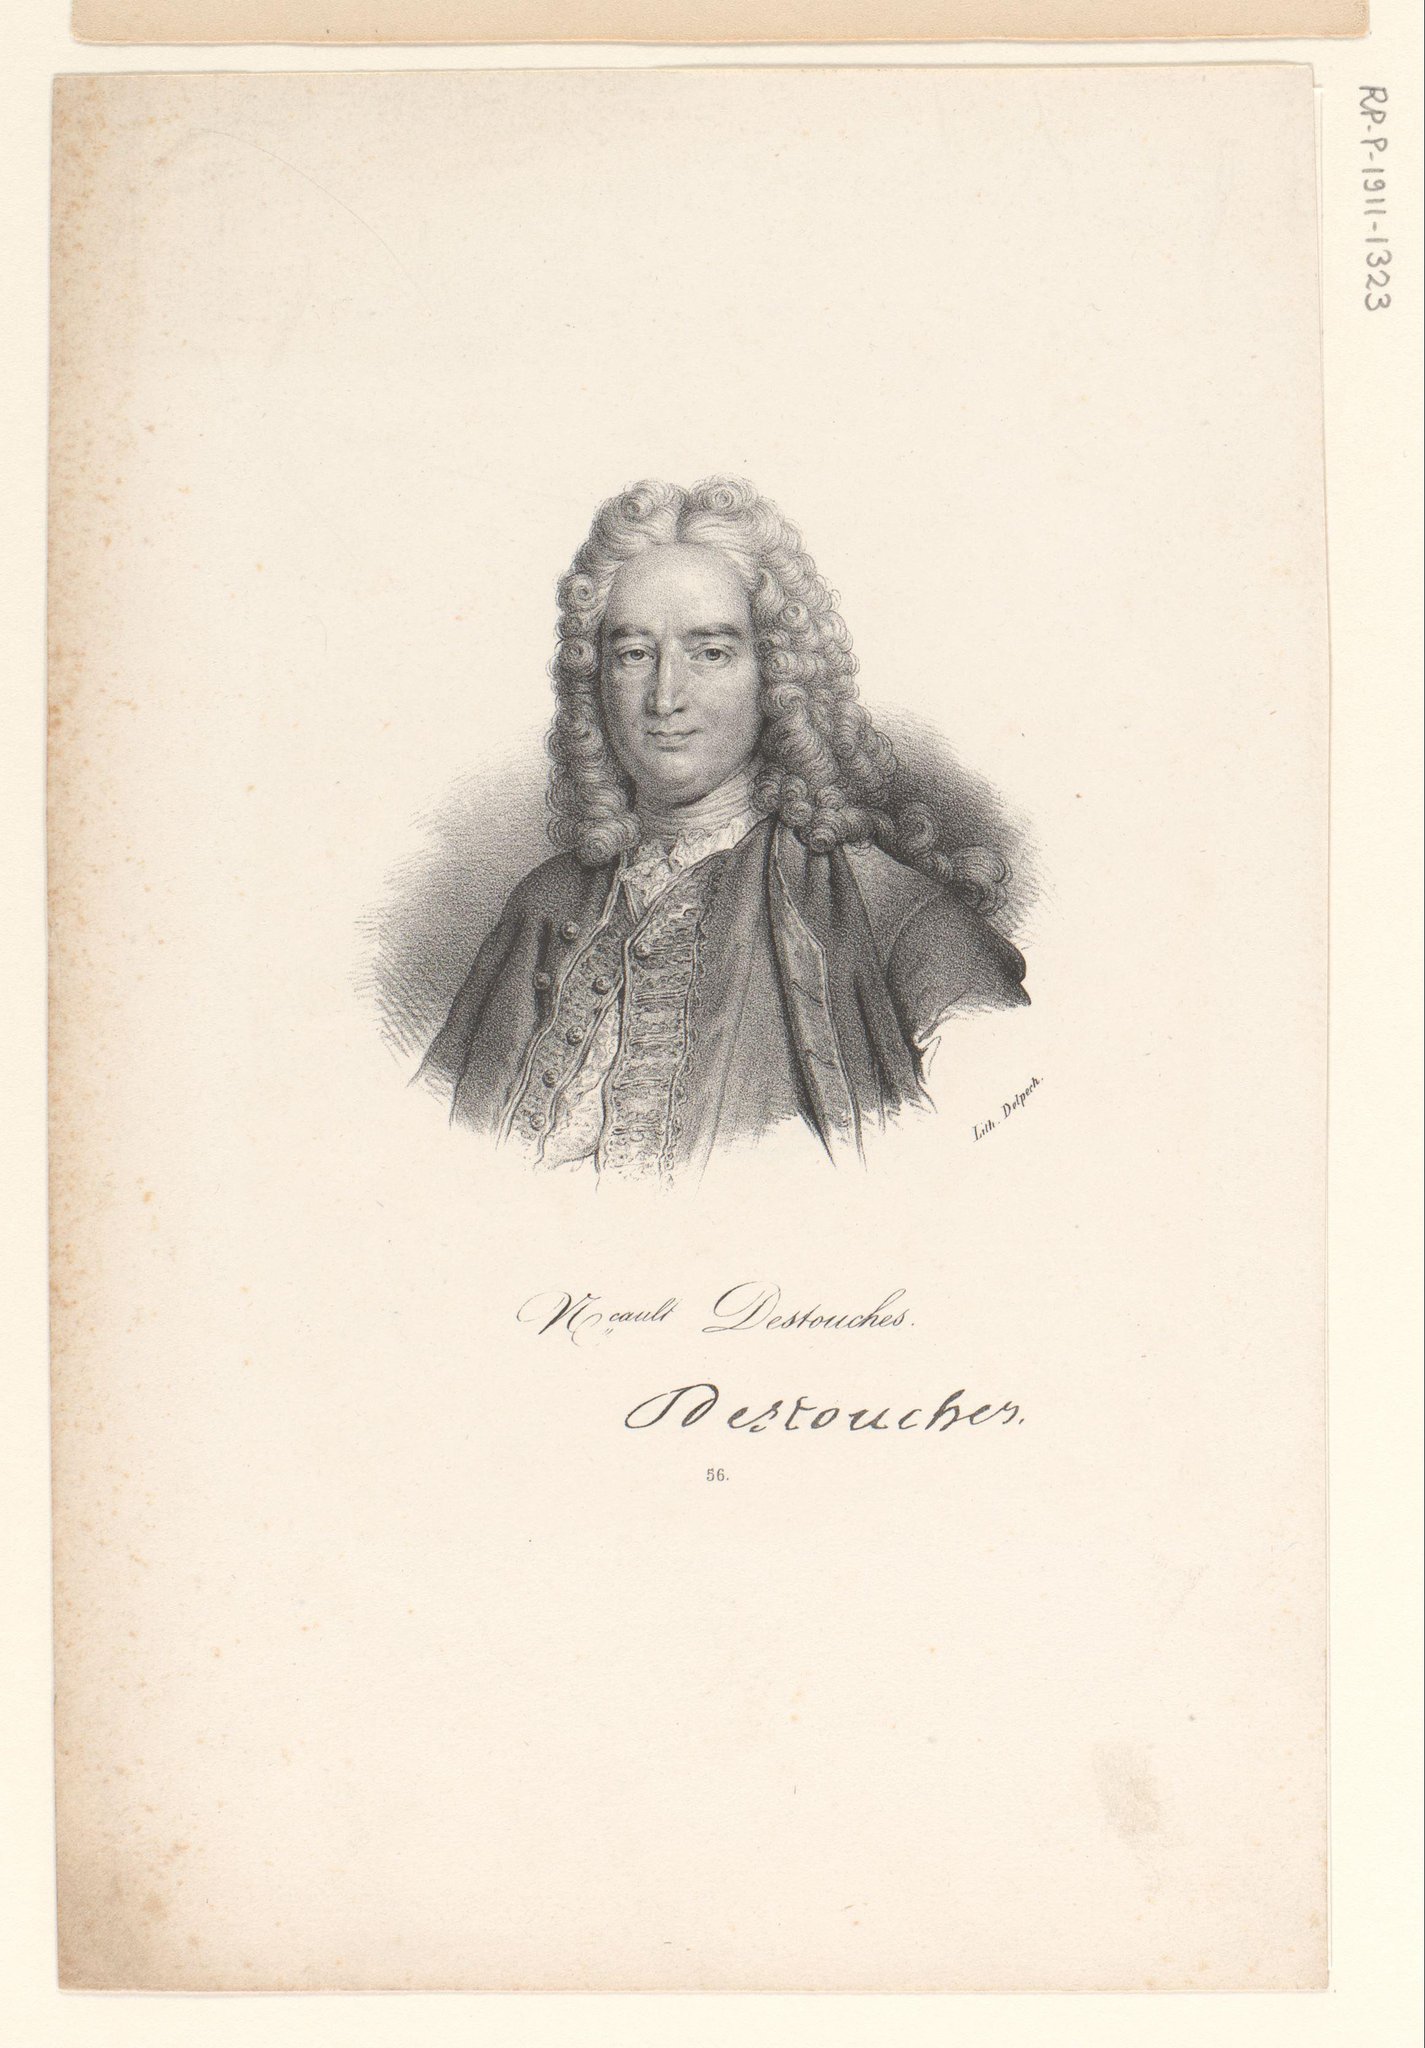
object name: print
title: Portret van Philippe Néricault Destouches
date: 1818-1842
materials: paper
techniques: lithograph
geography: paris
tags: philippe néricault destouches, historical persons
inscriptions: collector's mark: Lugt 2228a